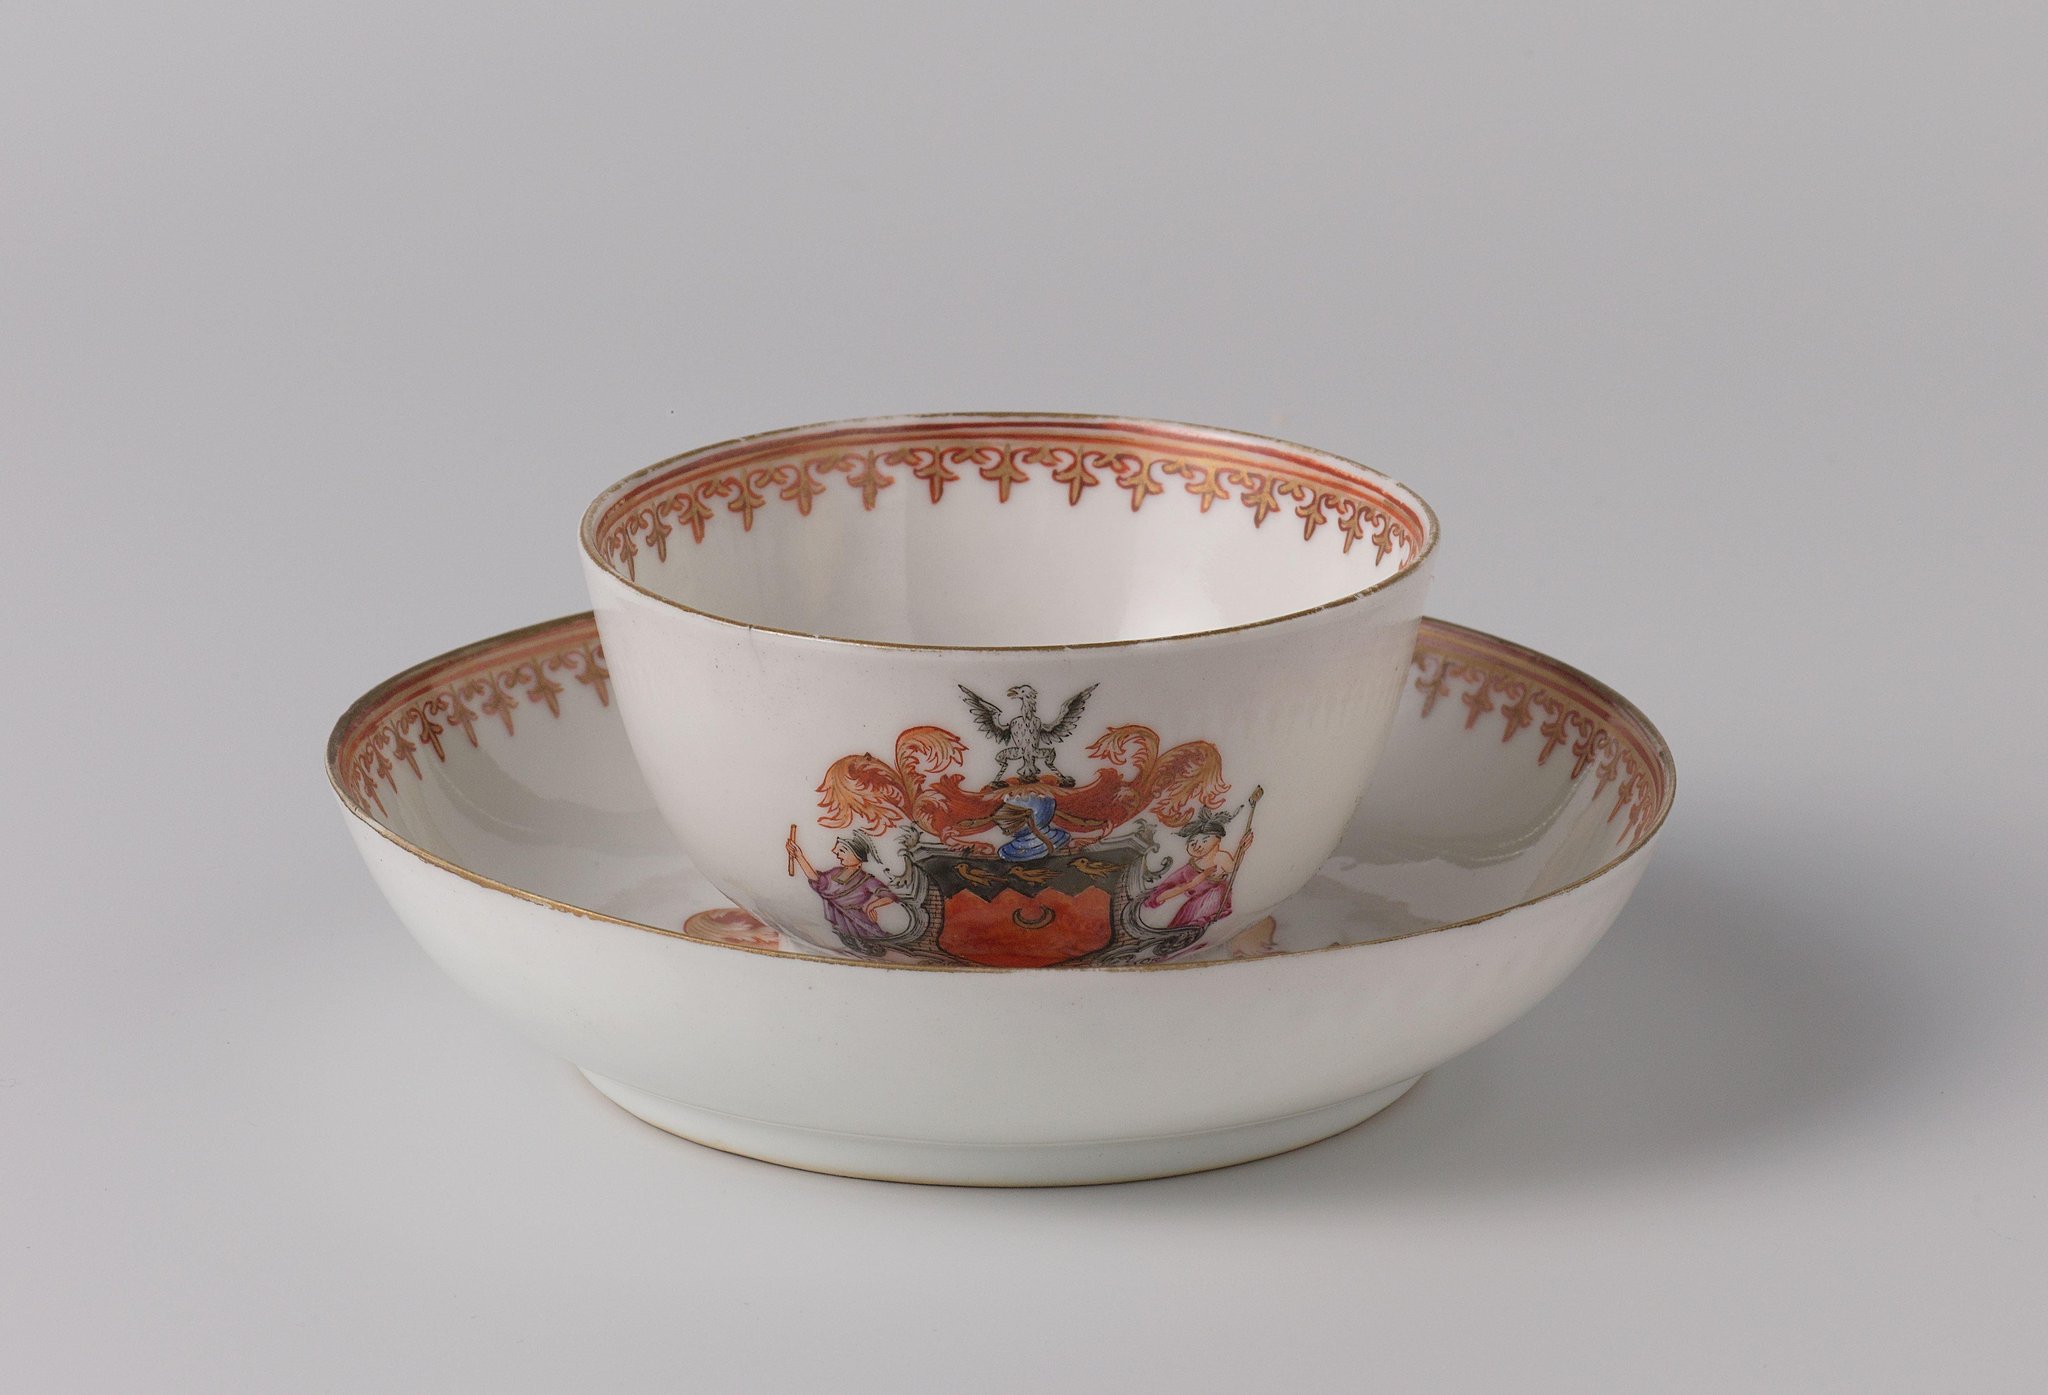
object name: kop en schotel, kop en schotel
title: Cup with the arms of the Lovelace family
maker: Anonymous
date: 1725-1749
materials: glaze, gold, paint, porcelain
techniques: firing, gilding, turning, vitrification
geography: china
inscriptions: inscription: ‘PRAEMIUM VIRTUTIS HONOR’, label: ‘Lovelace’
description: Kop en schotel, beschilderd in emails en goud met het wapen van de familie Lovelace en een spearhead-rand.